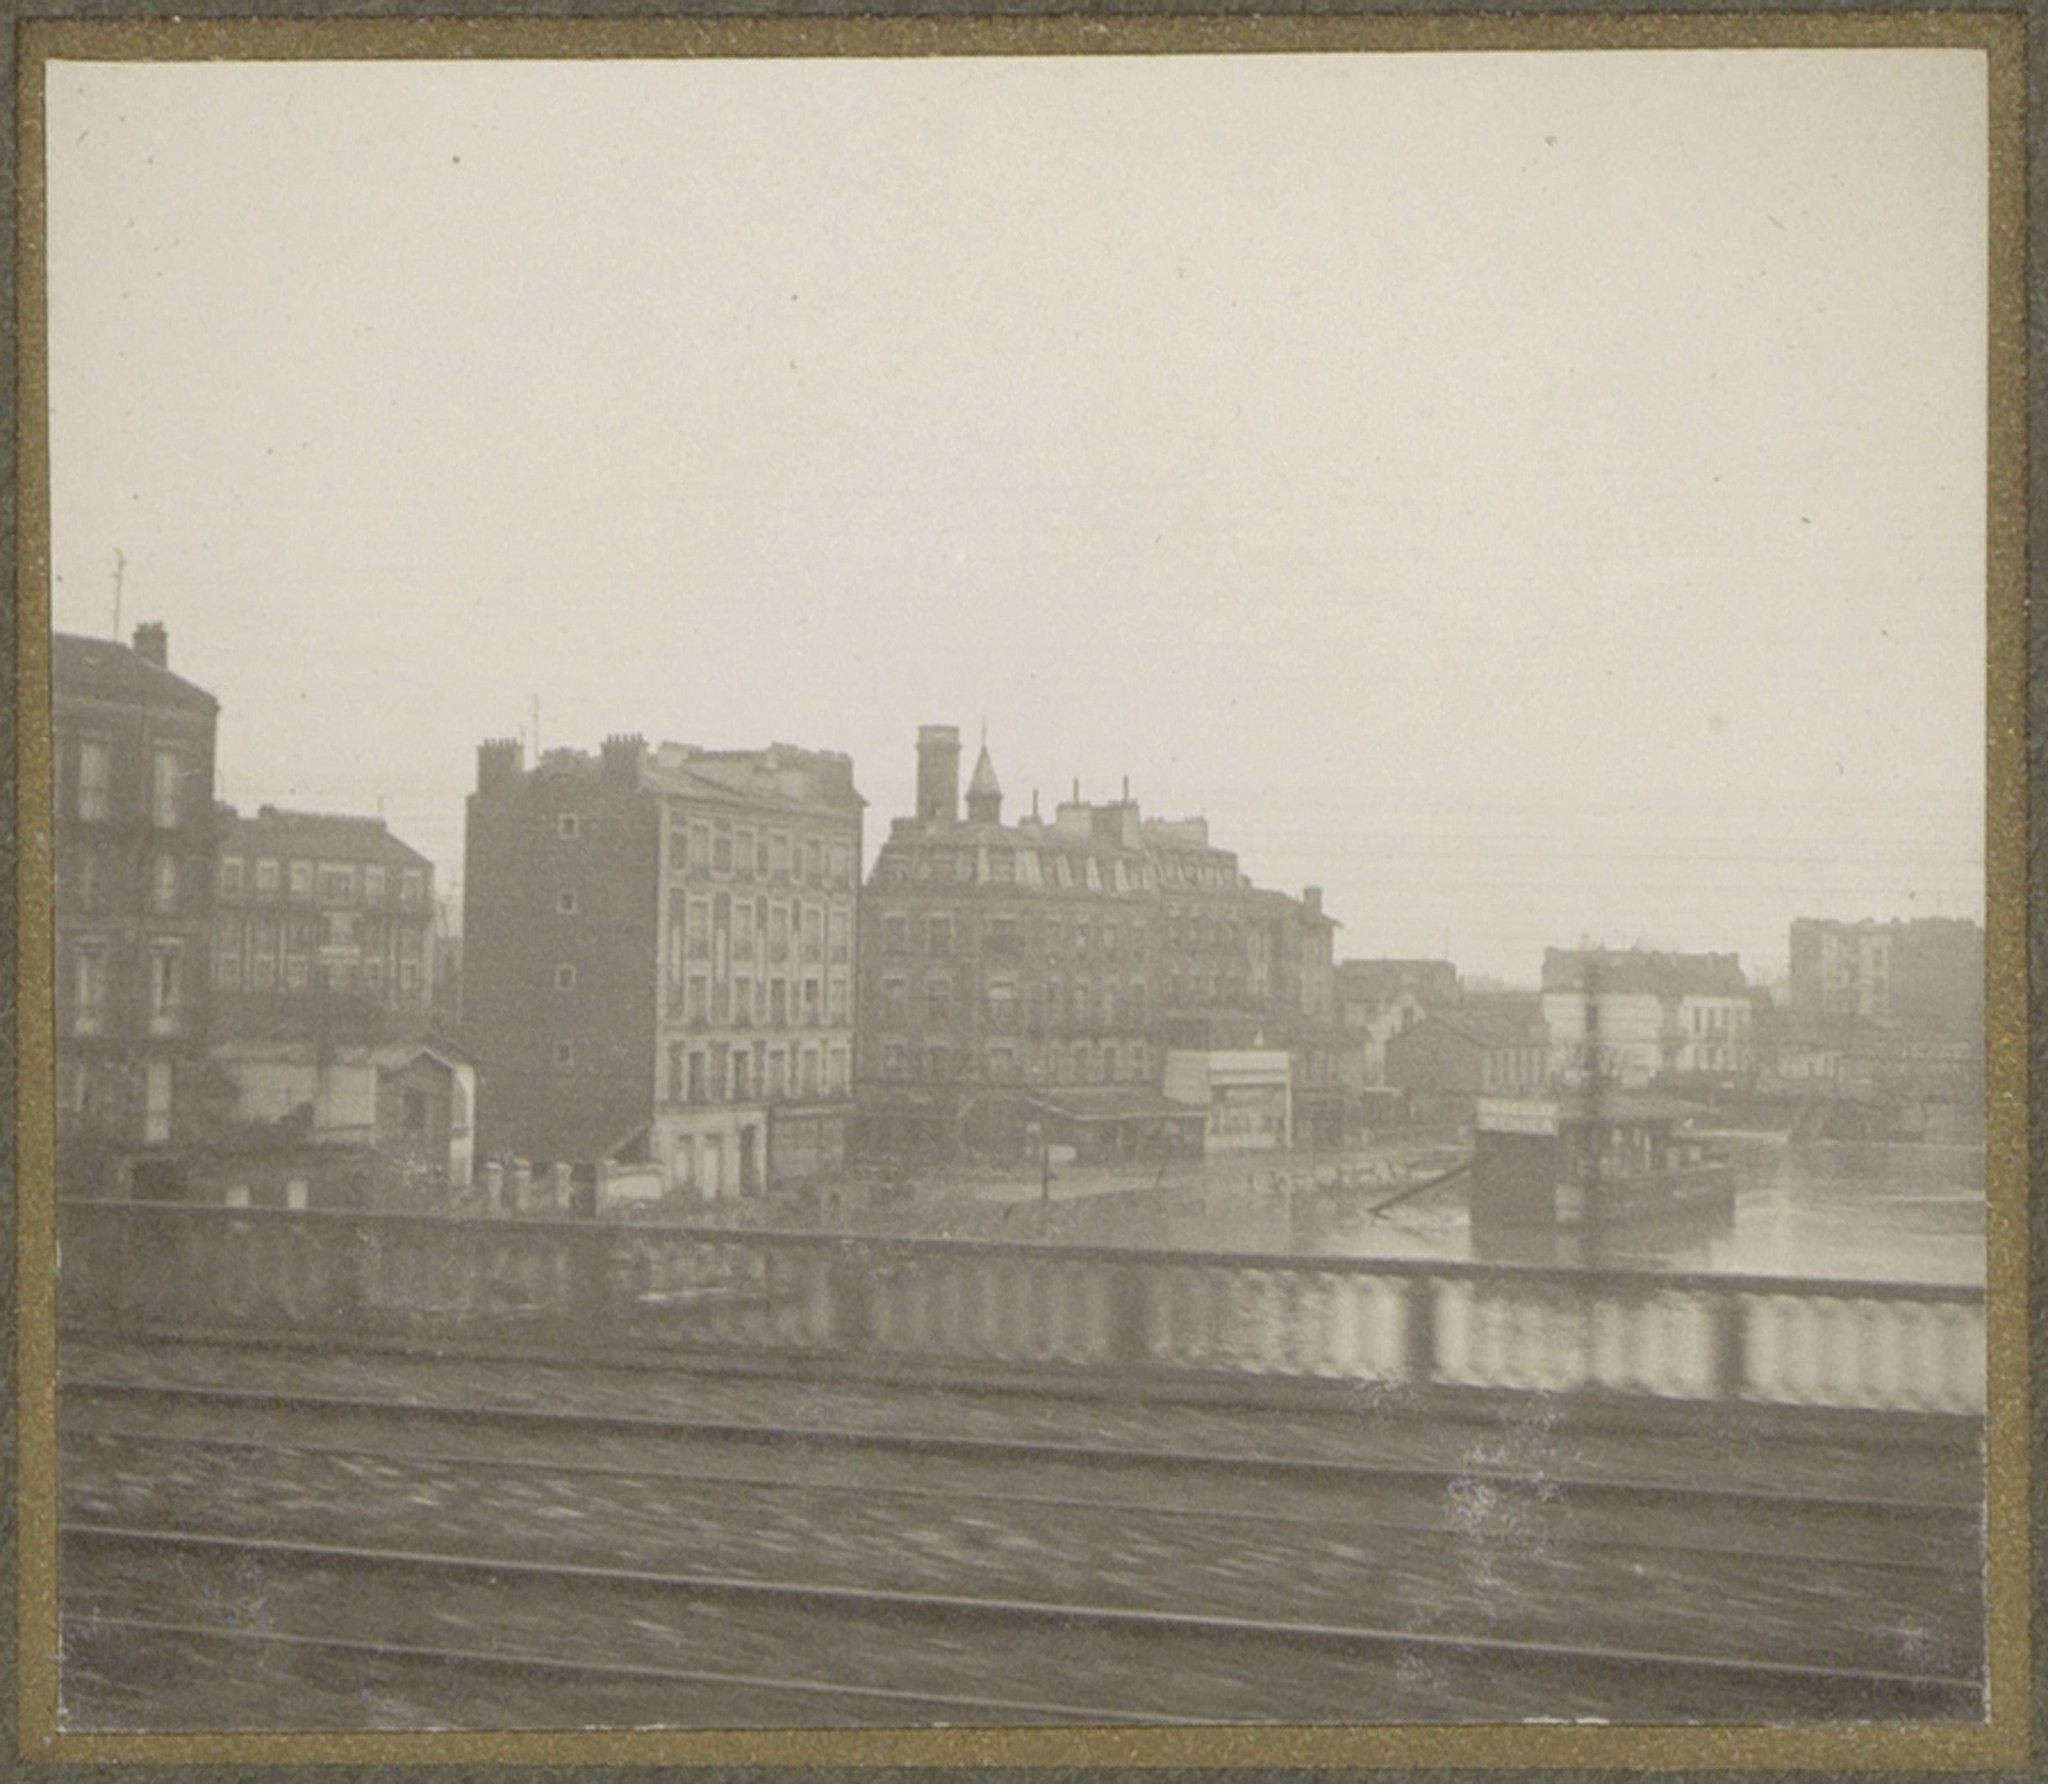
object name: photograph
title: Ondergelopen straat en gebouwen tijdens de overstroming van Parijs, gezien vanuit een trein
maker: g. dangereux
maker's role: fotograaf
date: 1901-1910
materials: photographic support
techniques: matte daylight collodion silver print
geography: paris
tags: flood (+ landscape with figures, staffage), paris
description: Onderdeel van fotoalbum overstroming Parijs en voorsteden 1910.